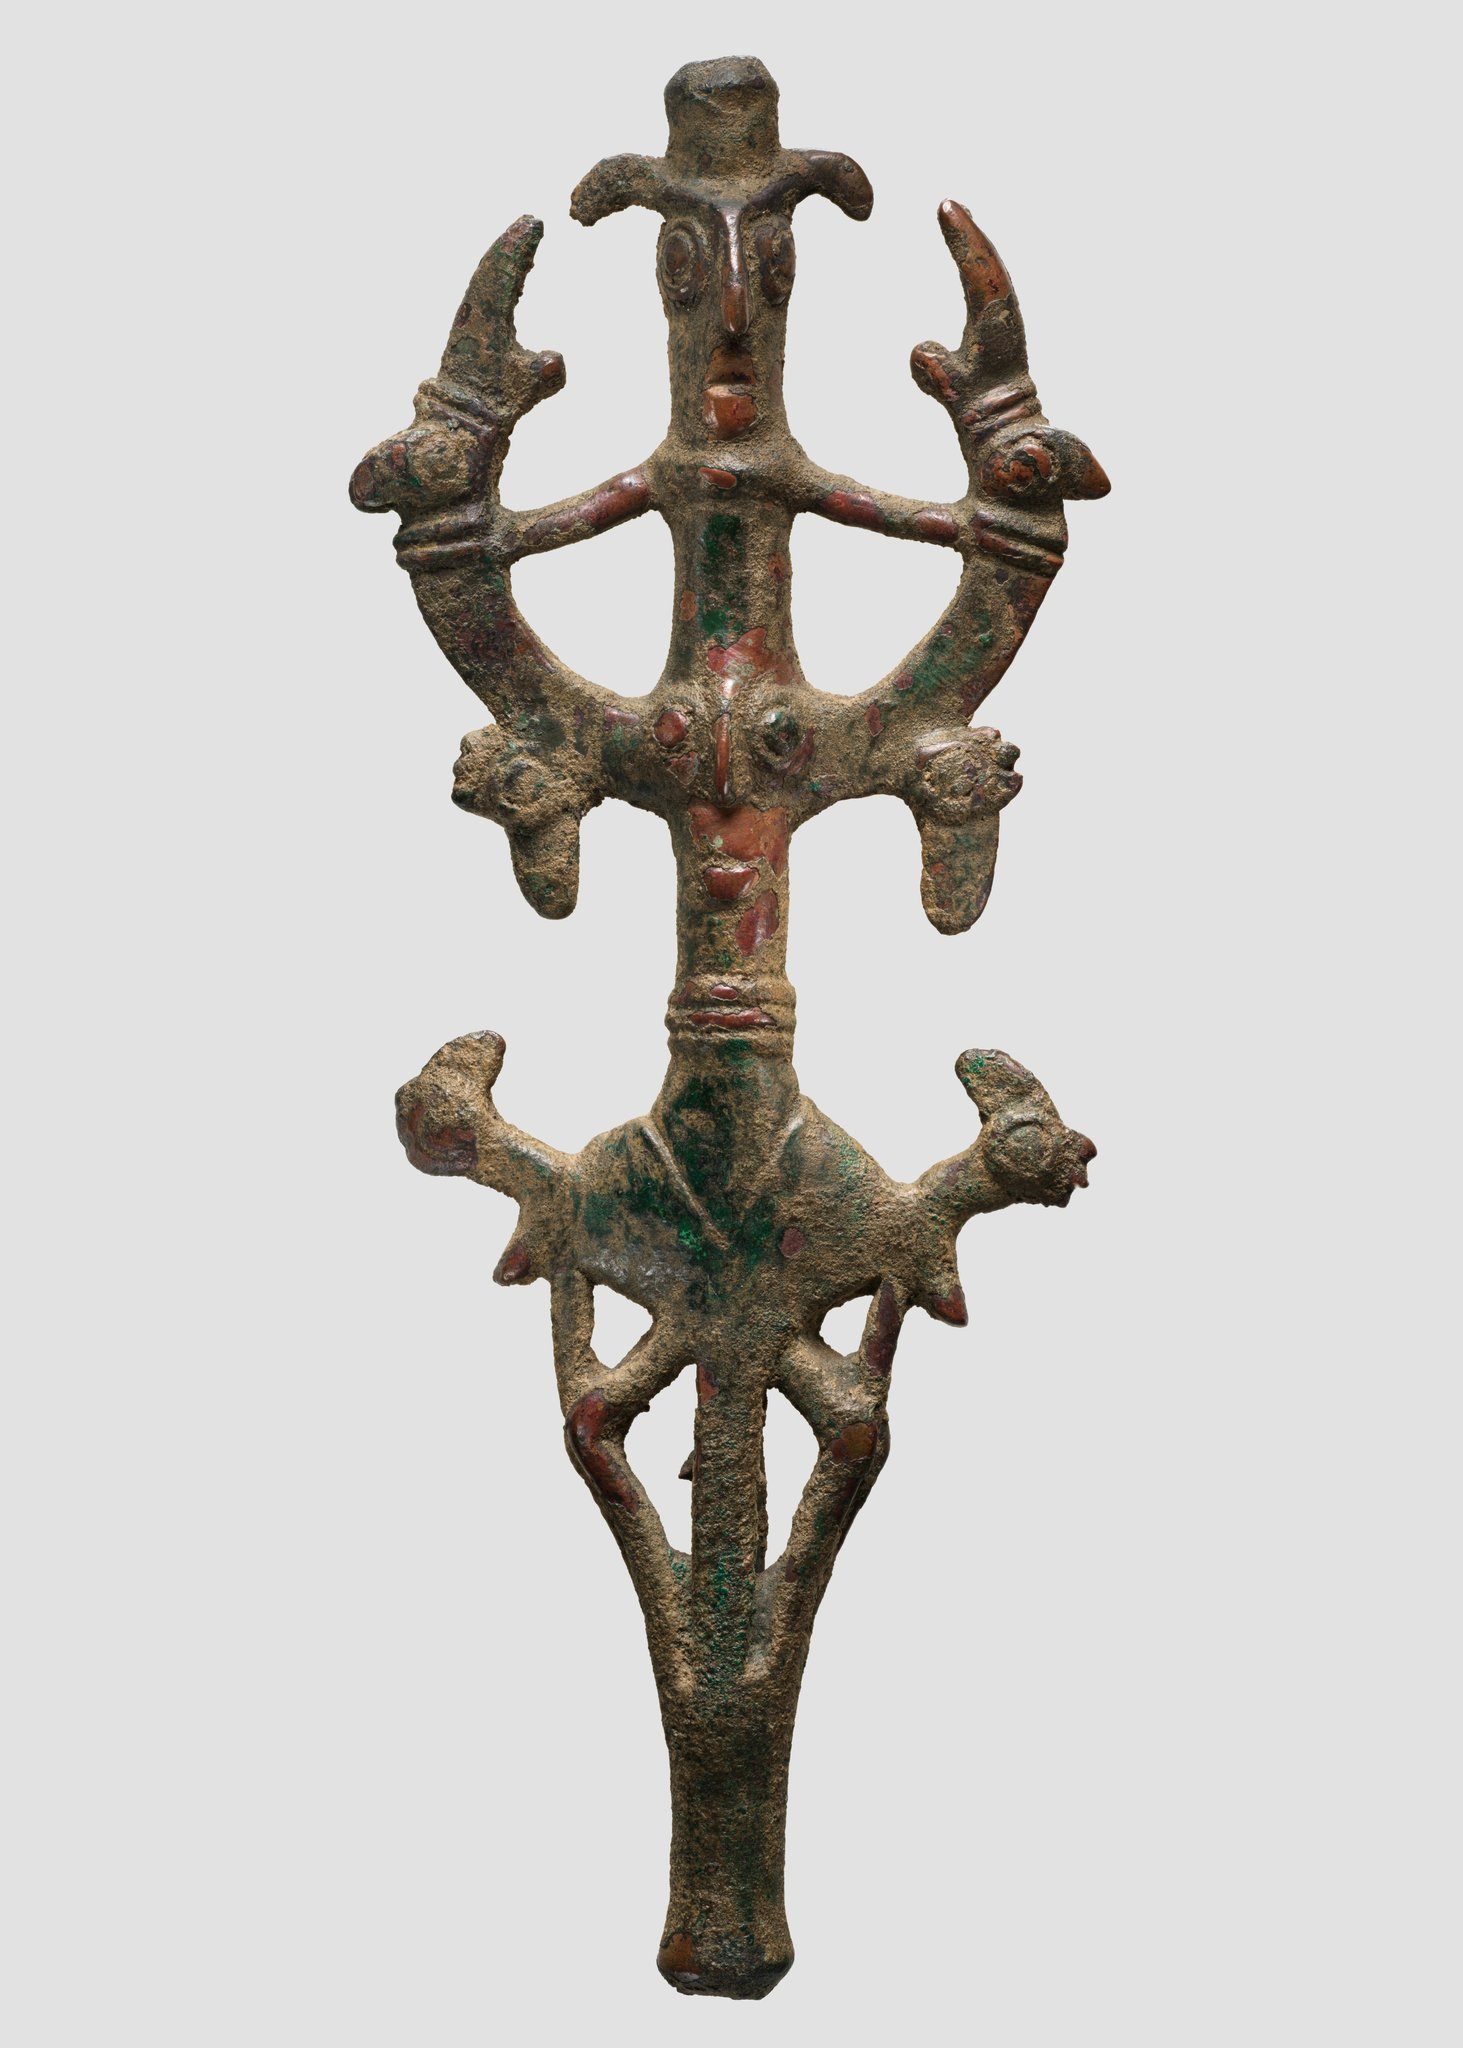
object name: standard top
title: Top for standard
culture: iranian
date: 800-601 BCE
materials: bronze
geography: iran, probably from luristan